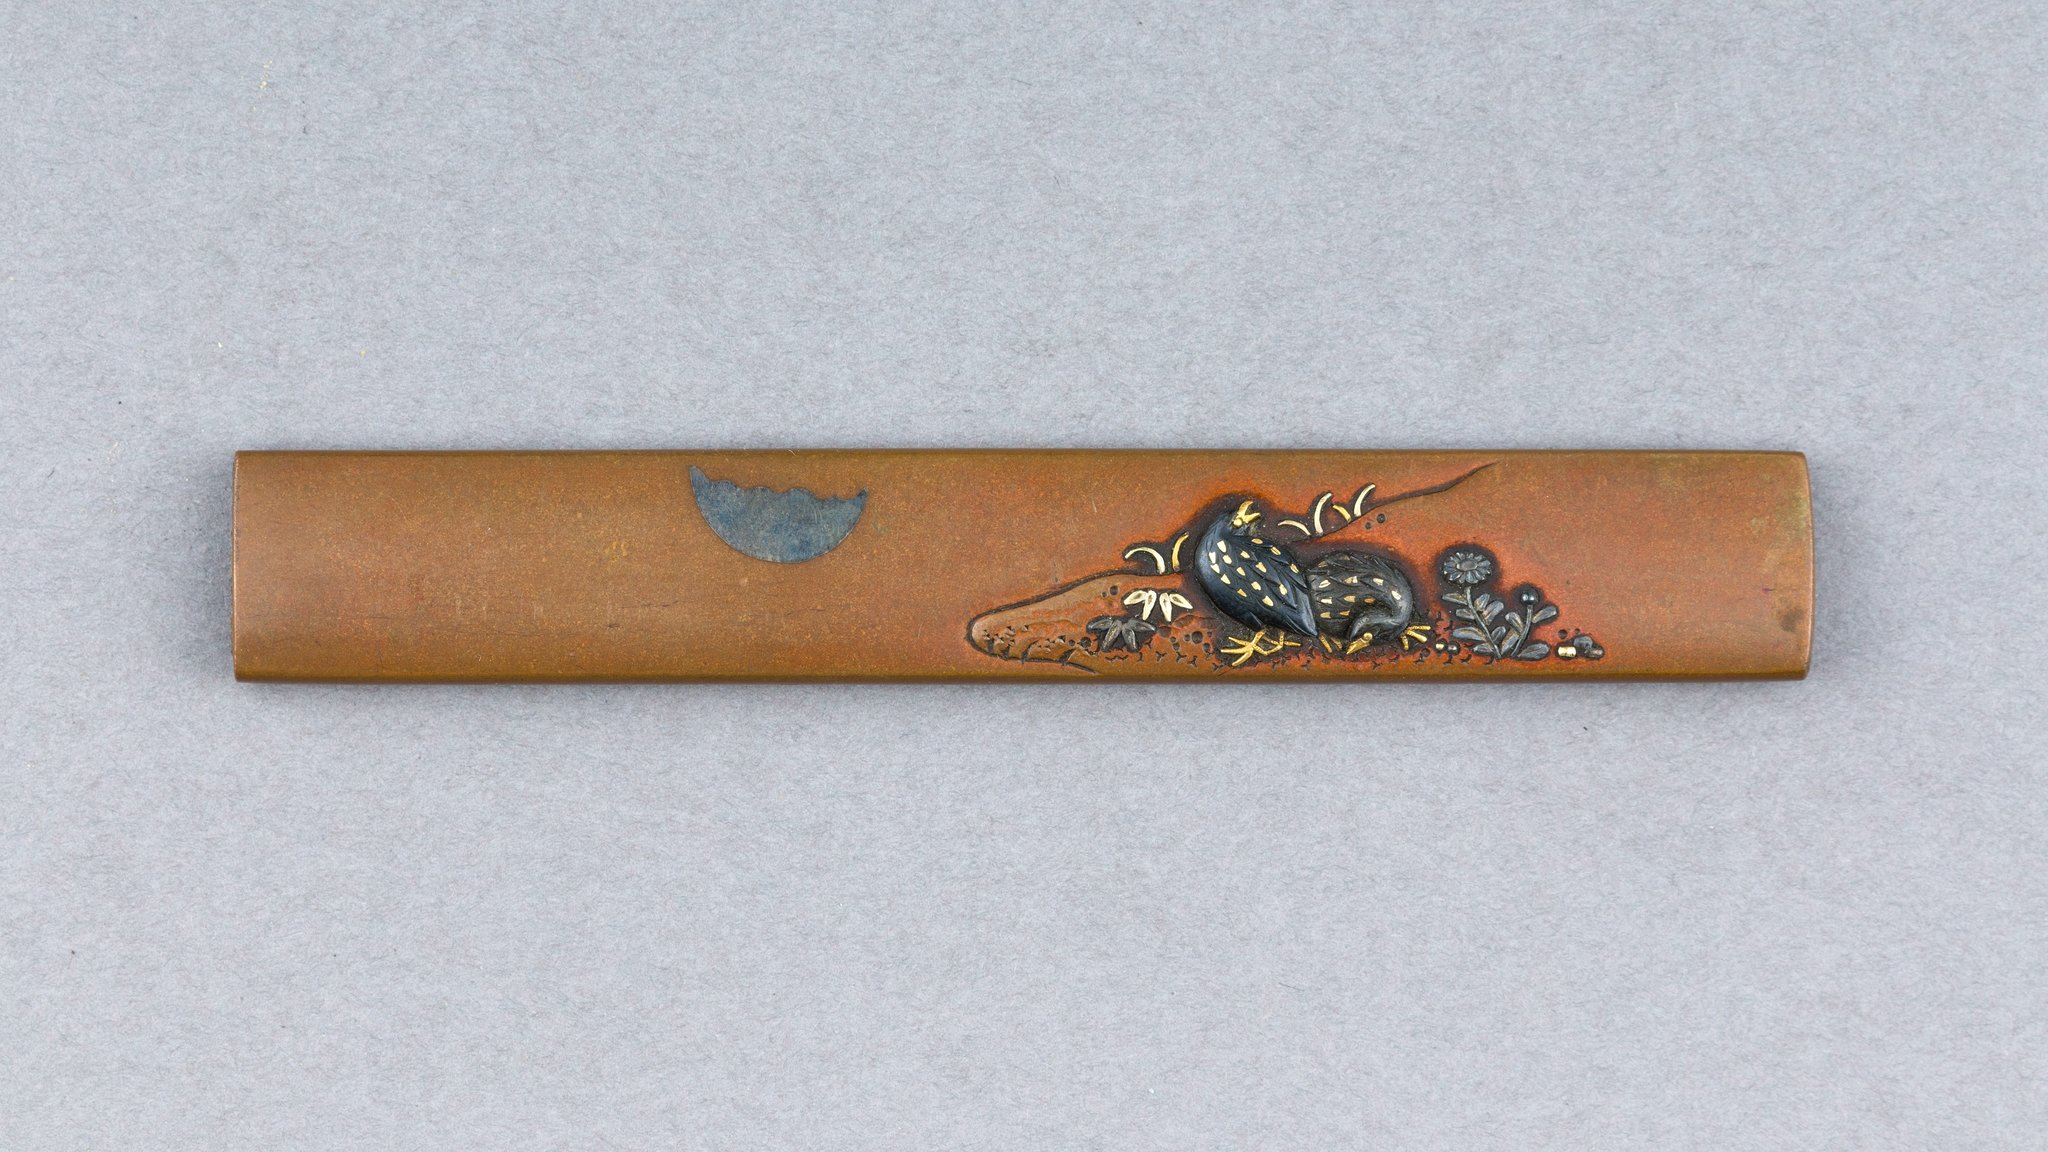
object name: knife handle kozuka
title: Knife Handle (Kozuka)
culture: japanese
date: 1615-1868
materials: copper, gold alloy, silver alloy, gold, silver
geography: japan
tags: birds